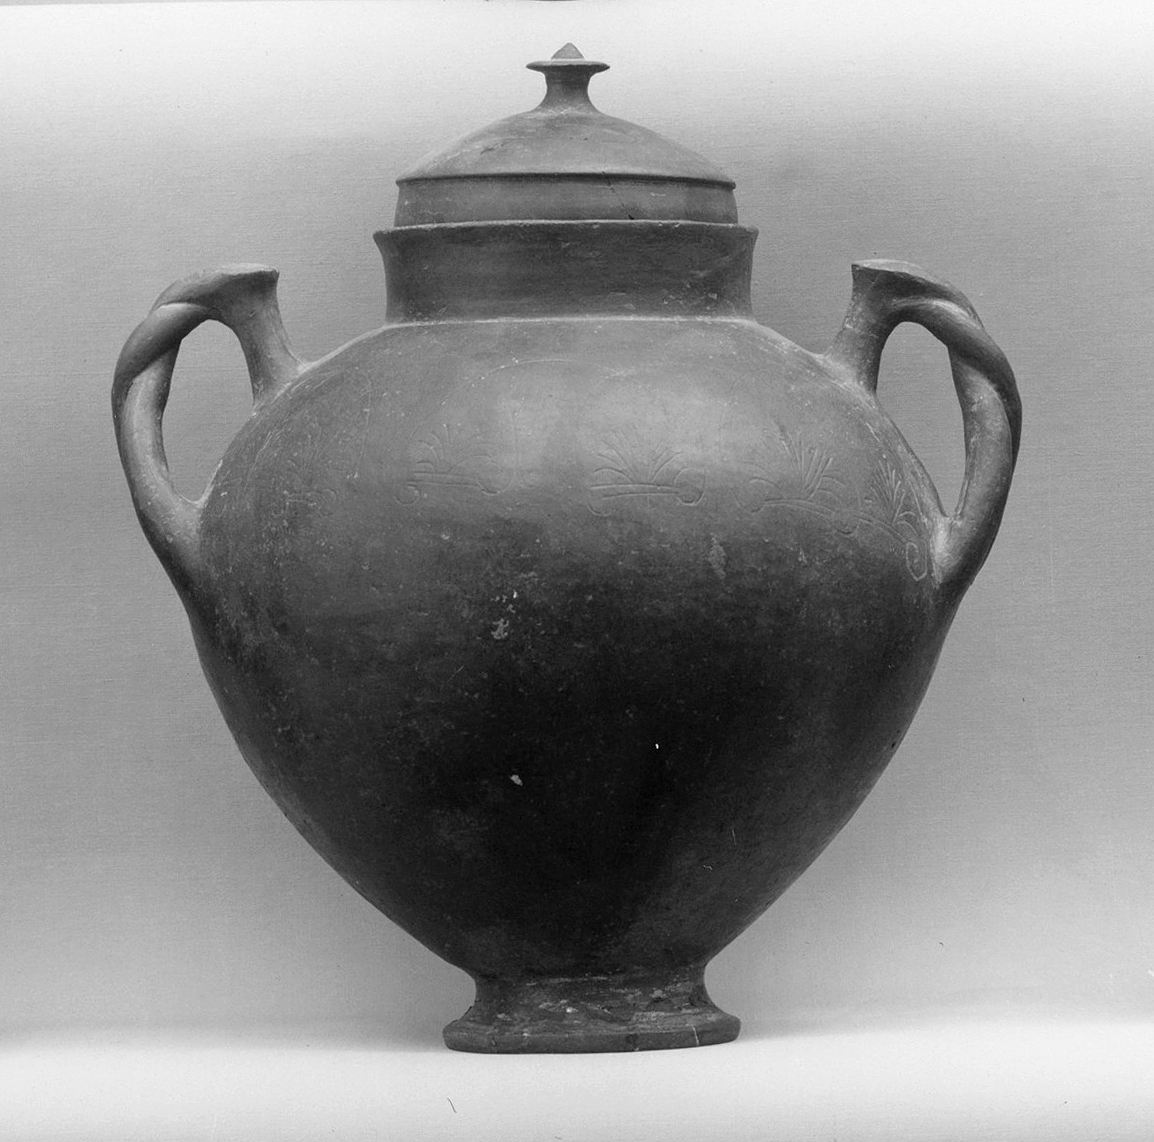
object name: vase with lid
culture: etruscan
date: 634-568 BCE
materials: terracotta